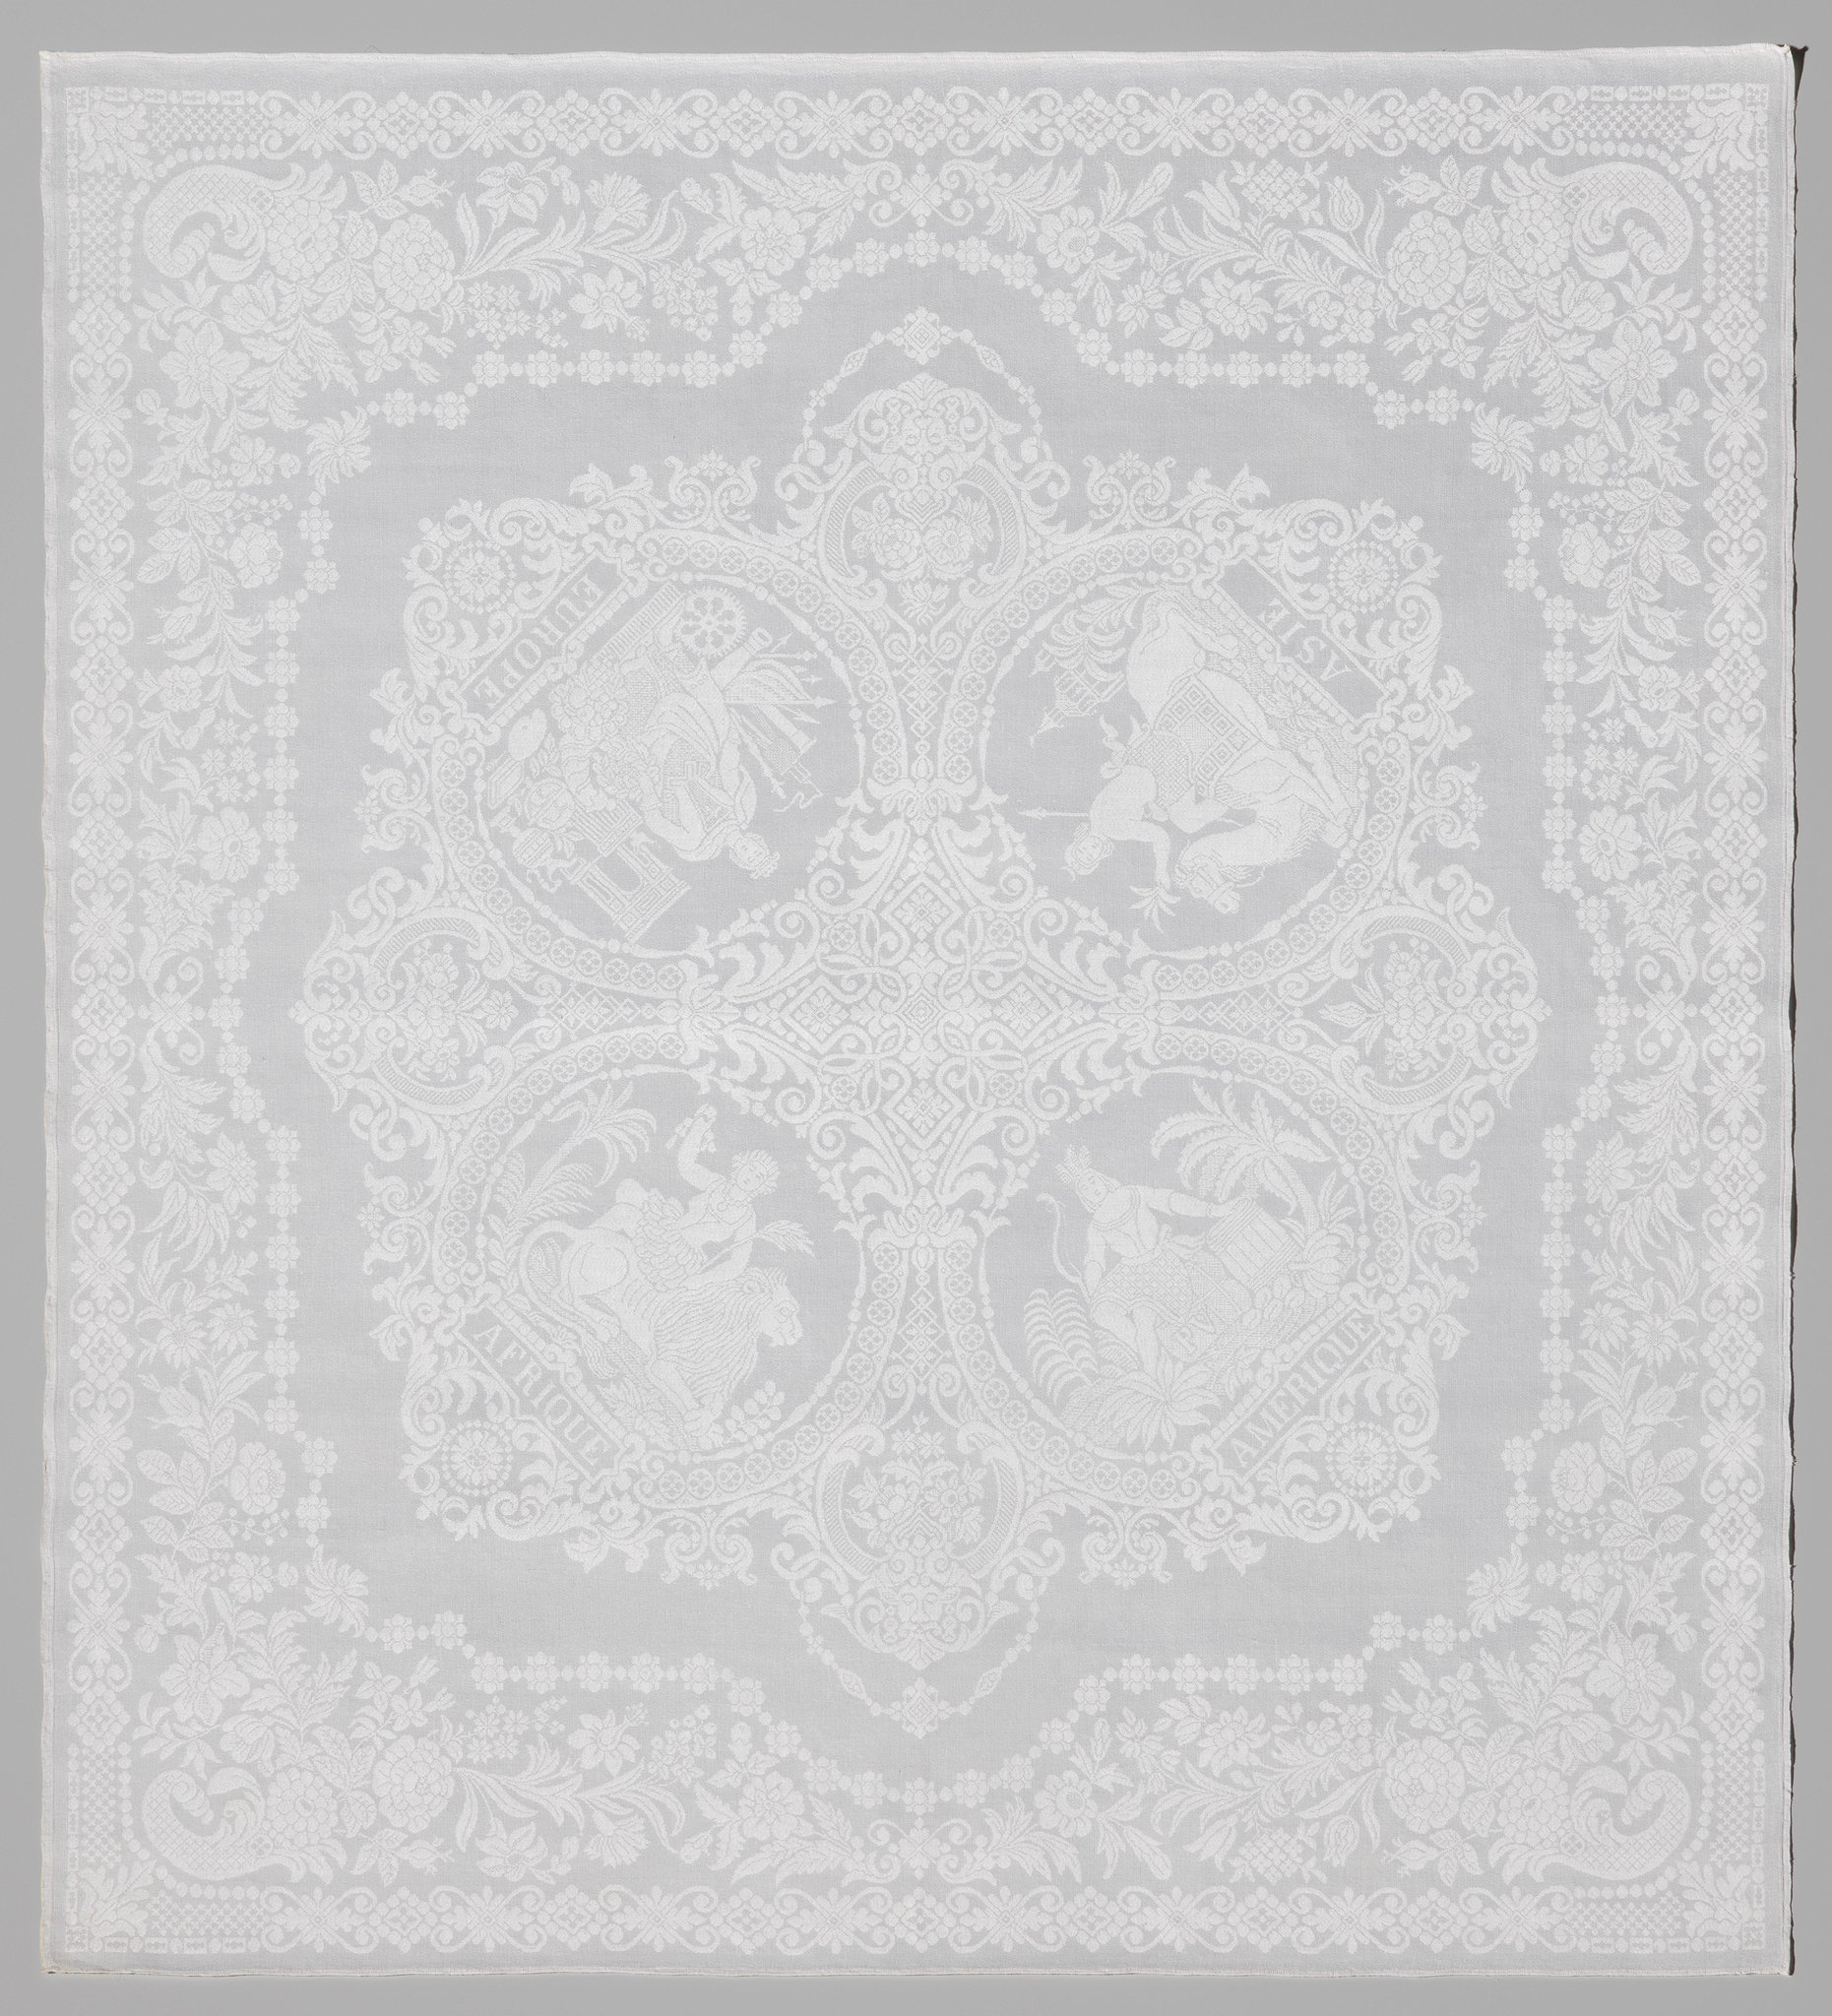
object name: napkin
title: Servet met personificaties van de vier werelddelen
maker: Anonymous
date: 1870-1890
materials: linen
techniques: damask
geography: france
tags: america represented allegorically; 'america' (ripa)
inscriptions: signature: ‘PV’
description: De Franstalige opschriften en de omstandigheid dat bij de personificatie van Europa vermoedelijk de Arc de Triomphe is afgebeeld, maken het waarschijnlijk dat het servet in Frankrijk vervaardigd is.